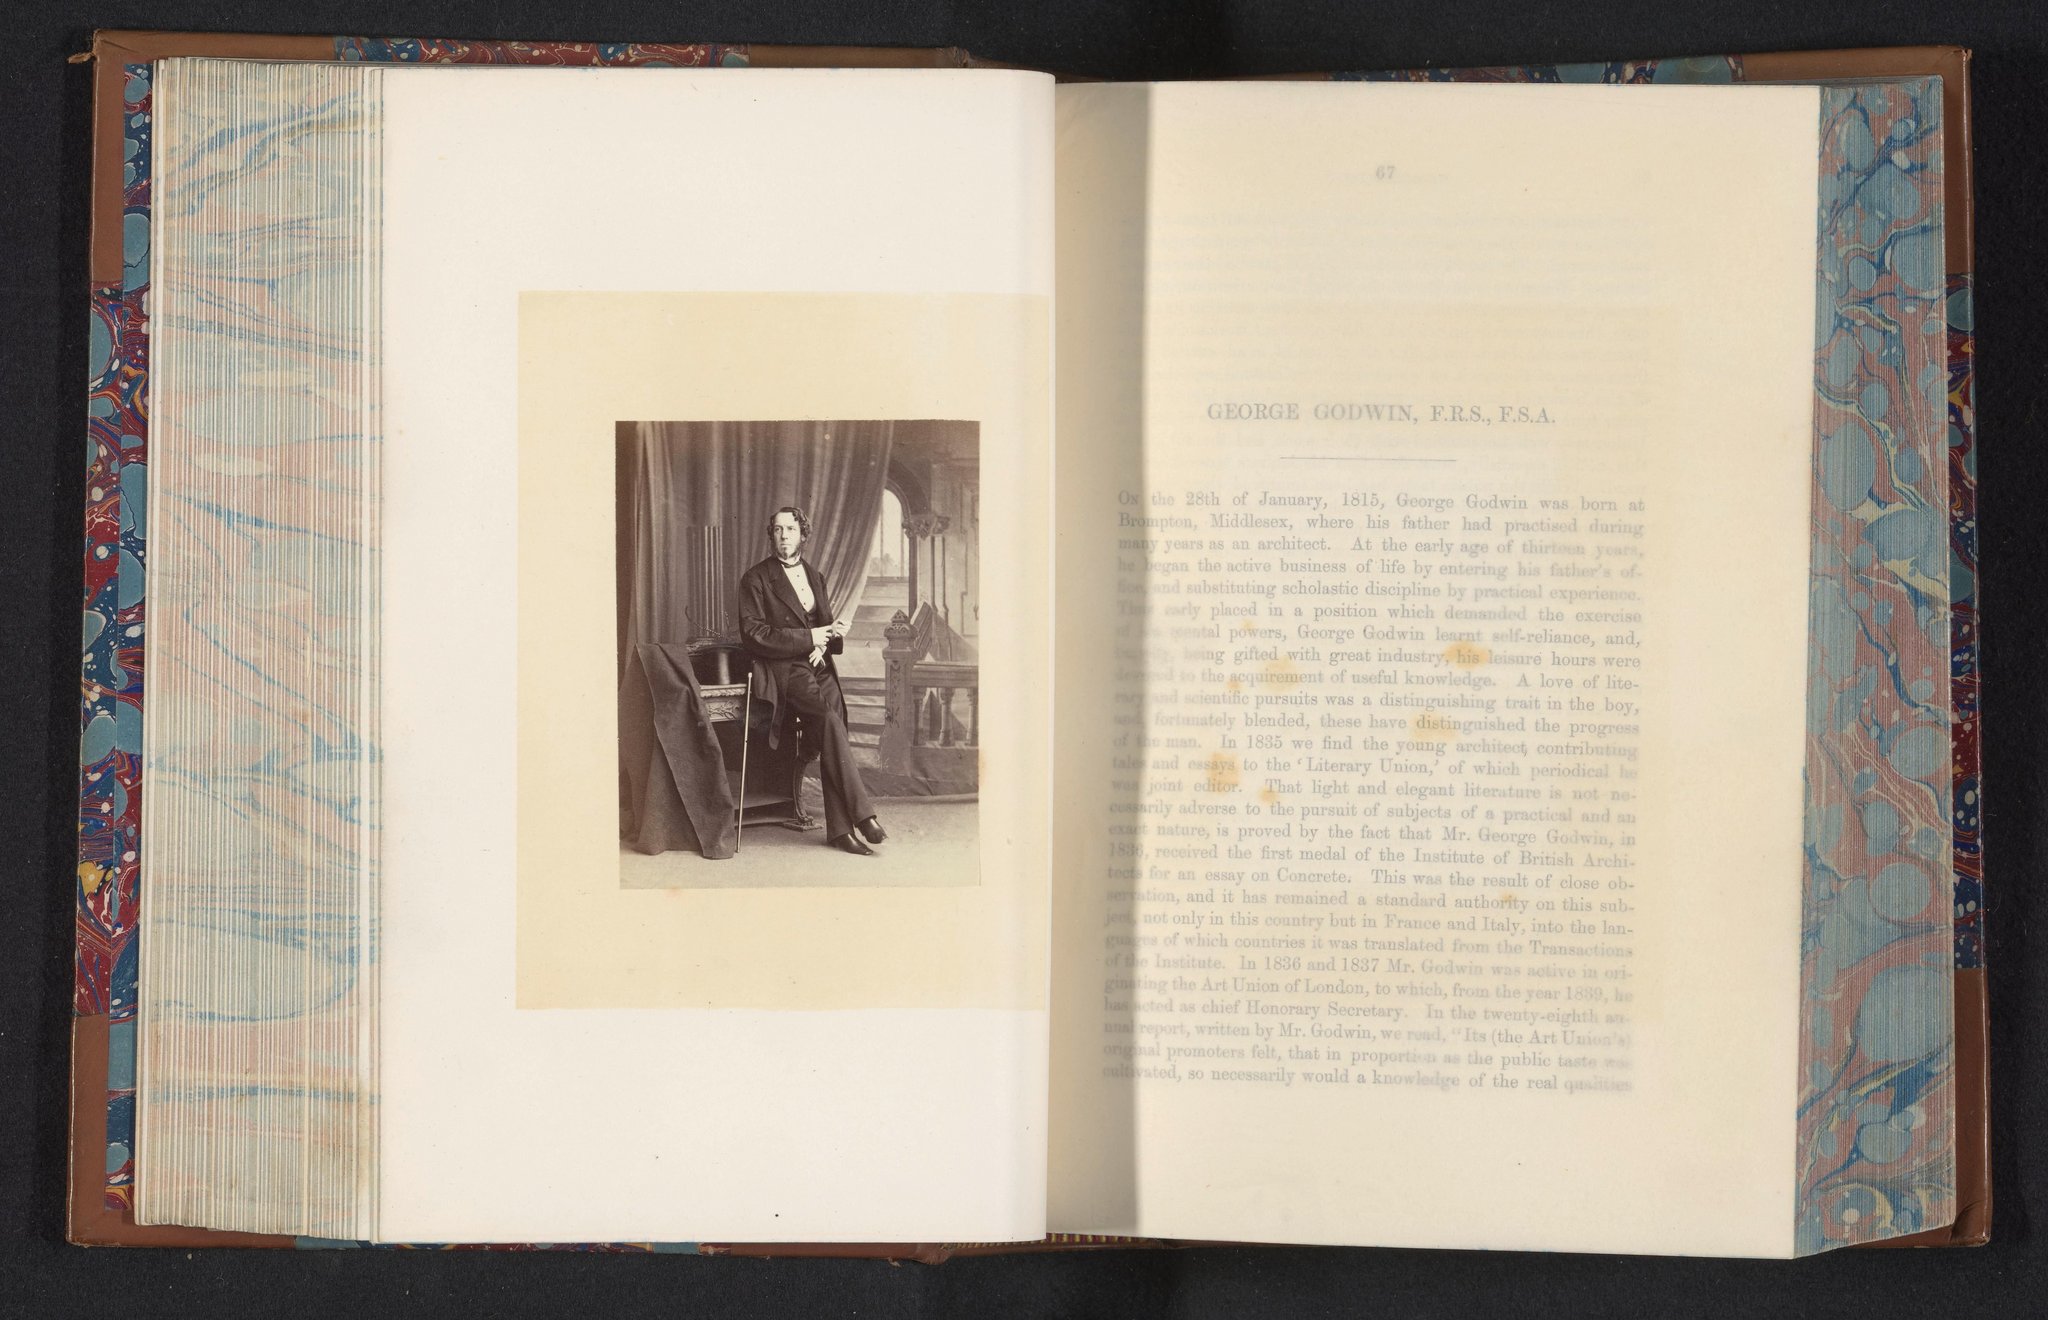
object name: photograph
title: Portret van George Godwin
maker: ernest edwards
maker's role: fotograaf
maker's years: 1837-1903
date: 1853-1867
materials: photographic support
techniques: albumen print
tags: studio requisites ~ photographer, portrait, self-portrait of architect